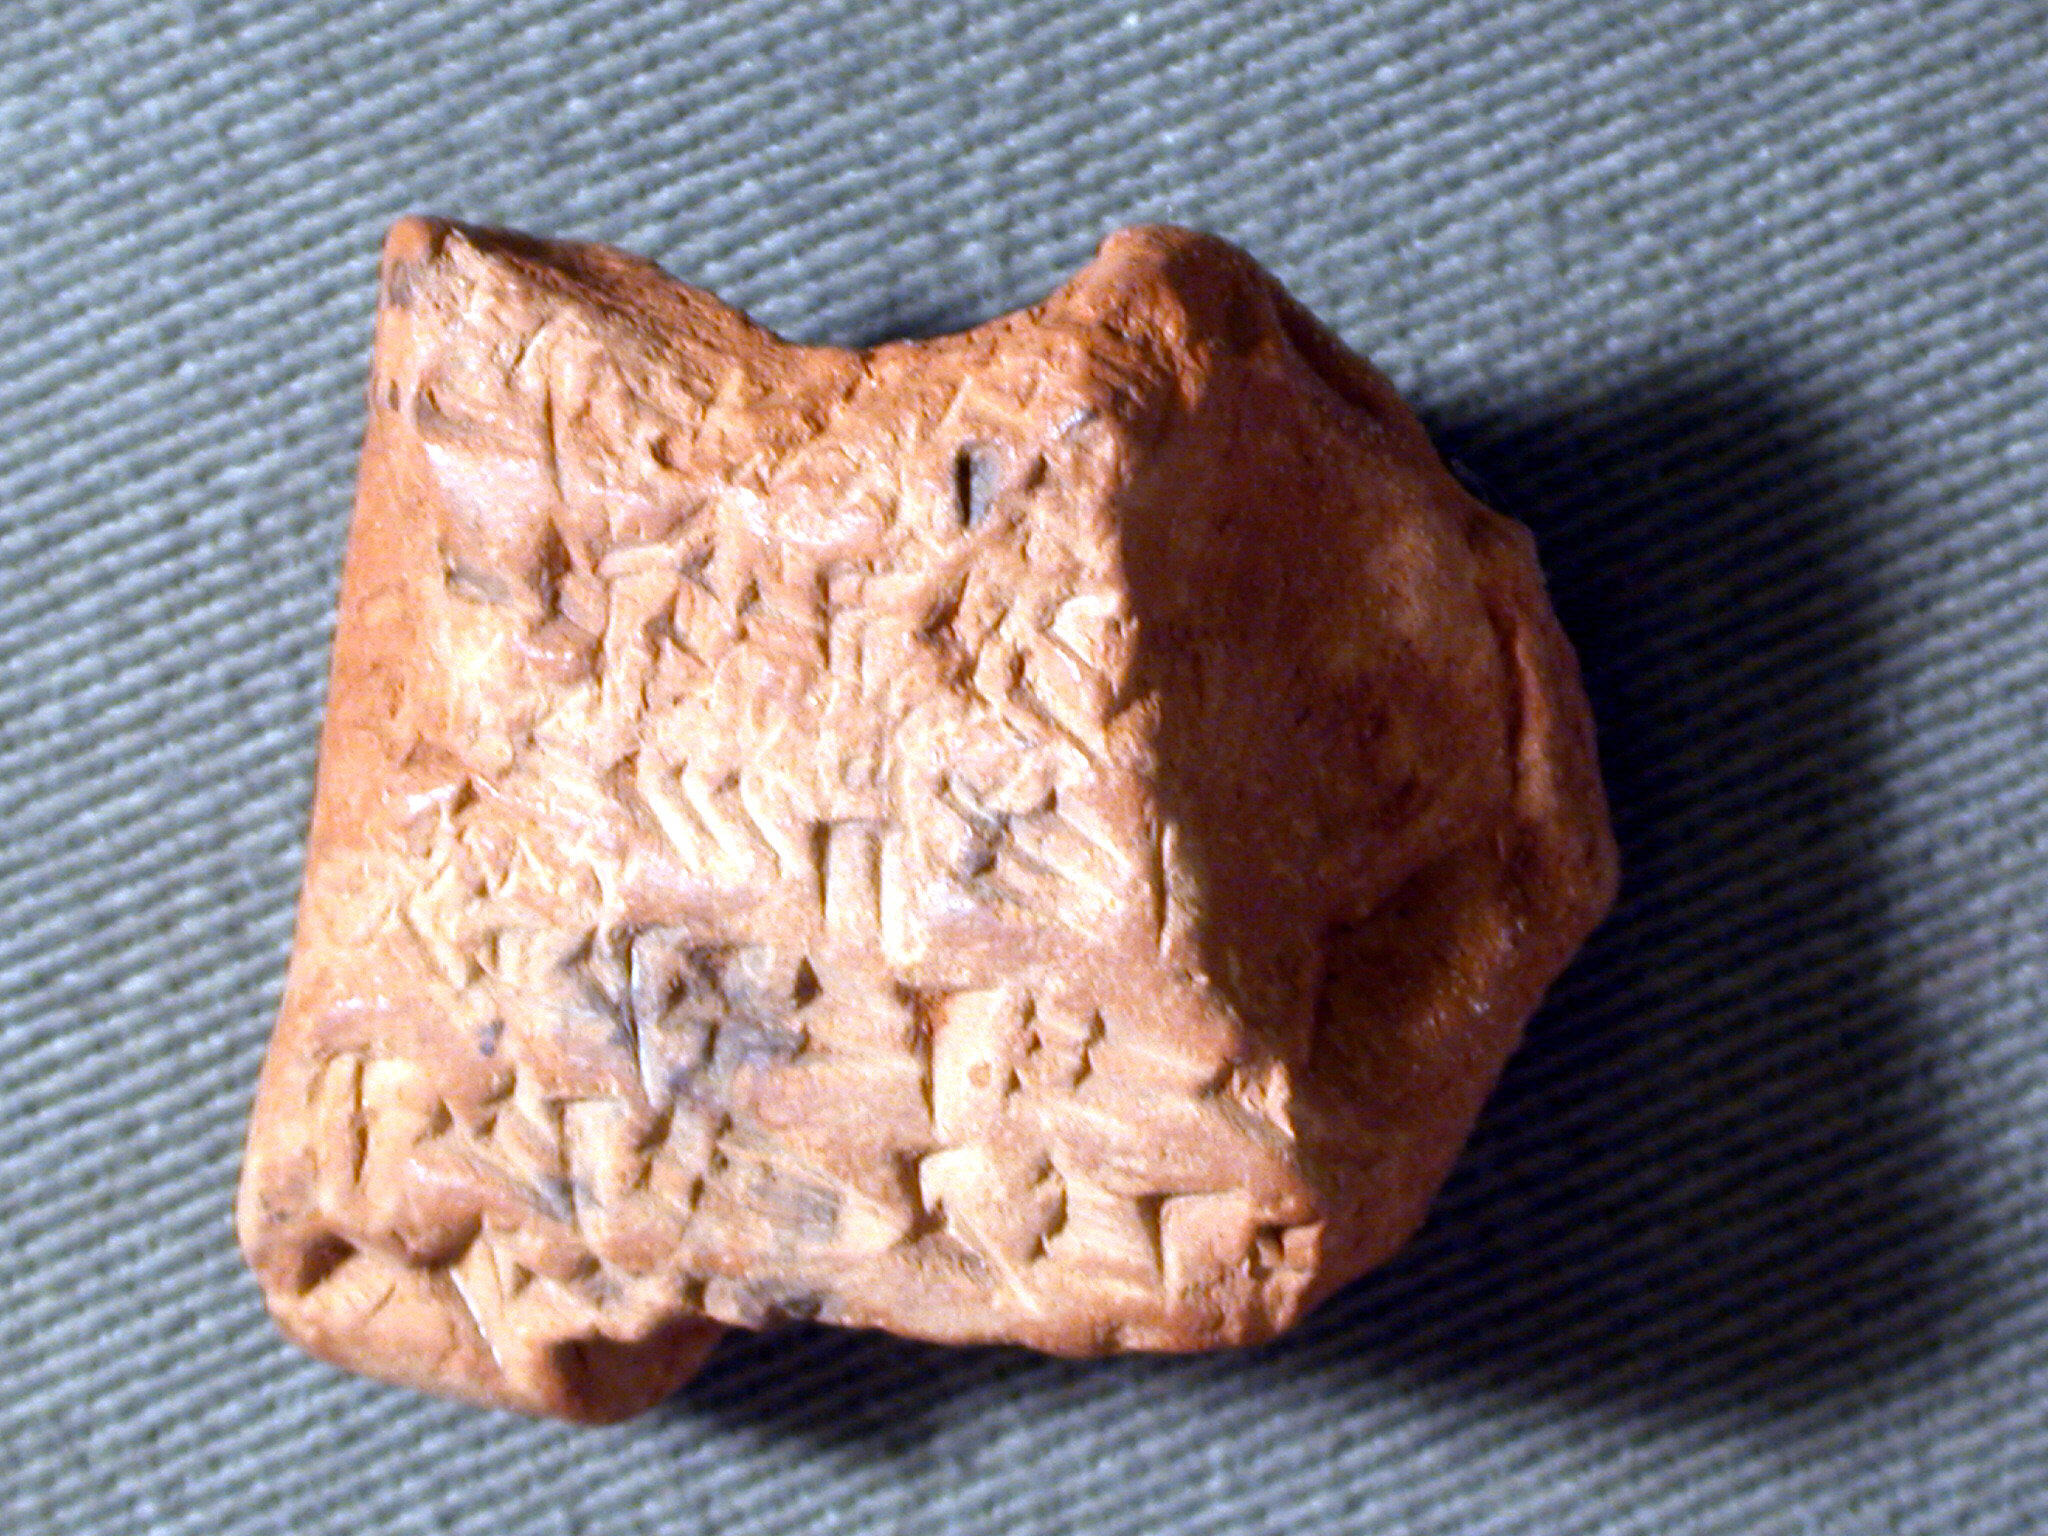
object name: cuneiform tablet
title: Cuneiform tablet: letter order, Ebabbar archive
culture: achaemenid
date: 487 BCE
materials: clay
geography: mesopotamia